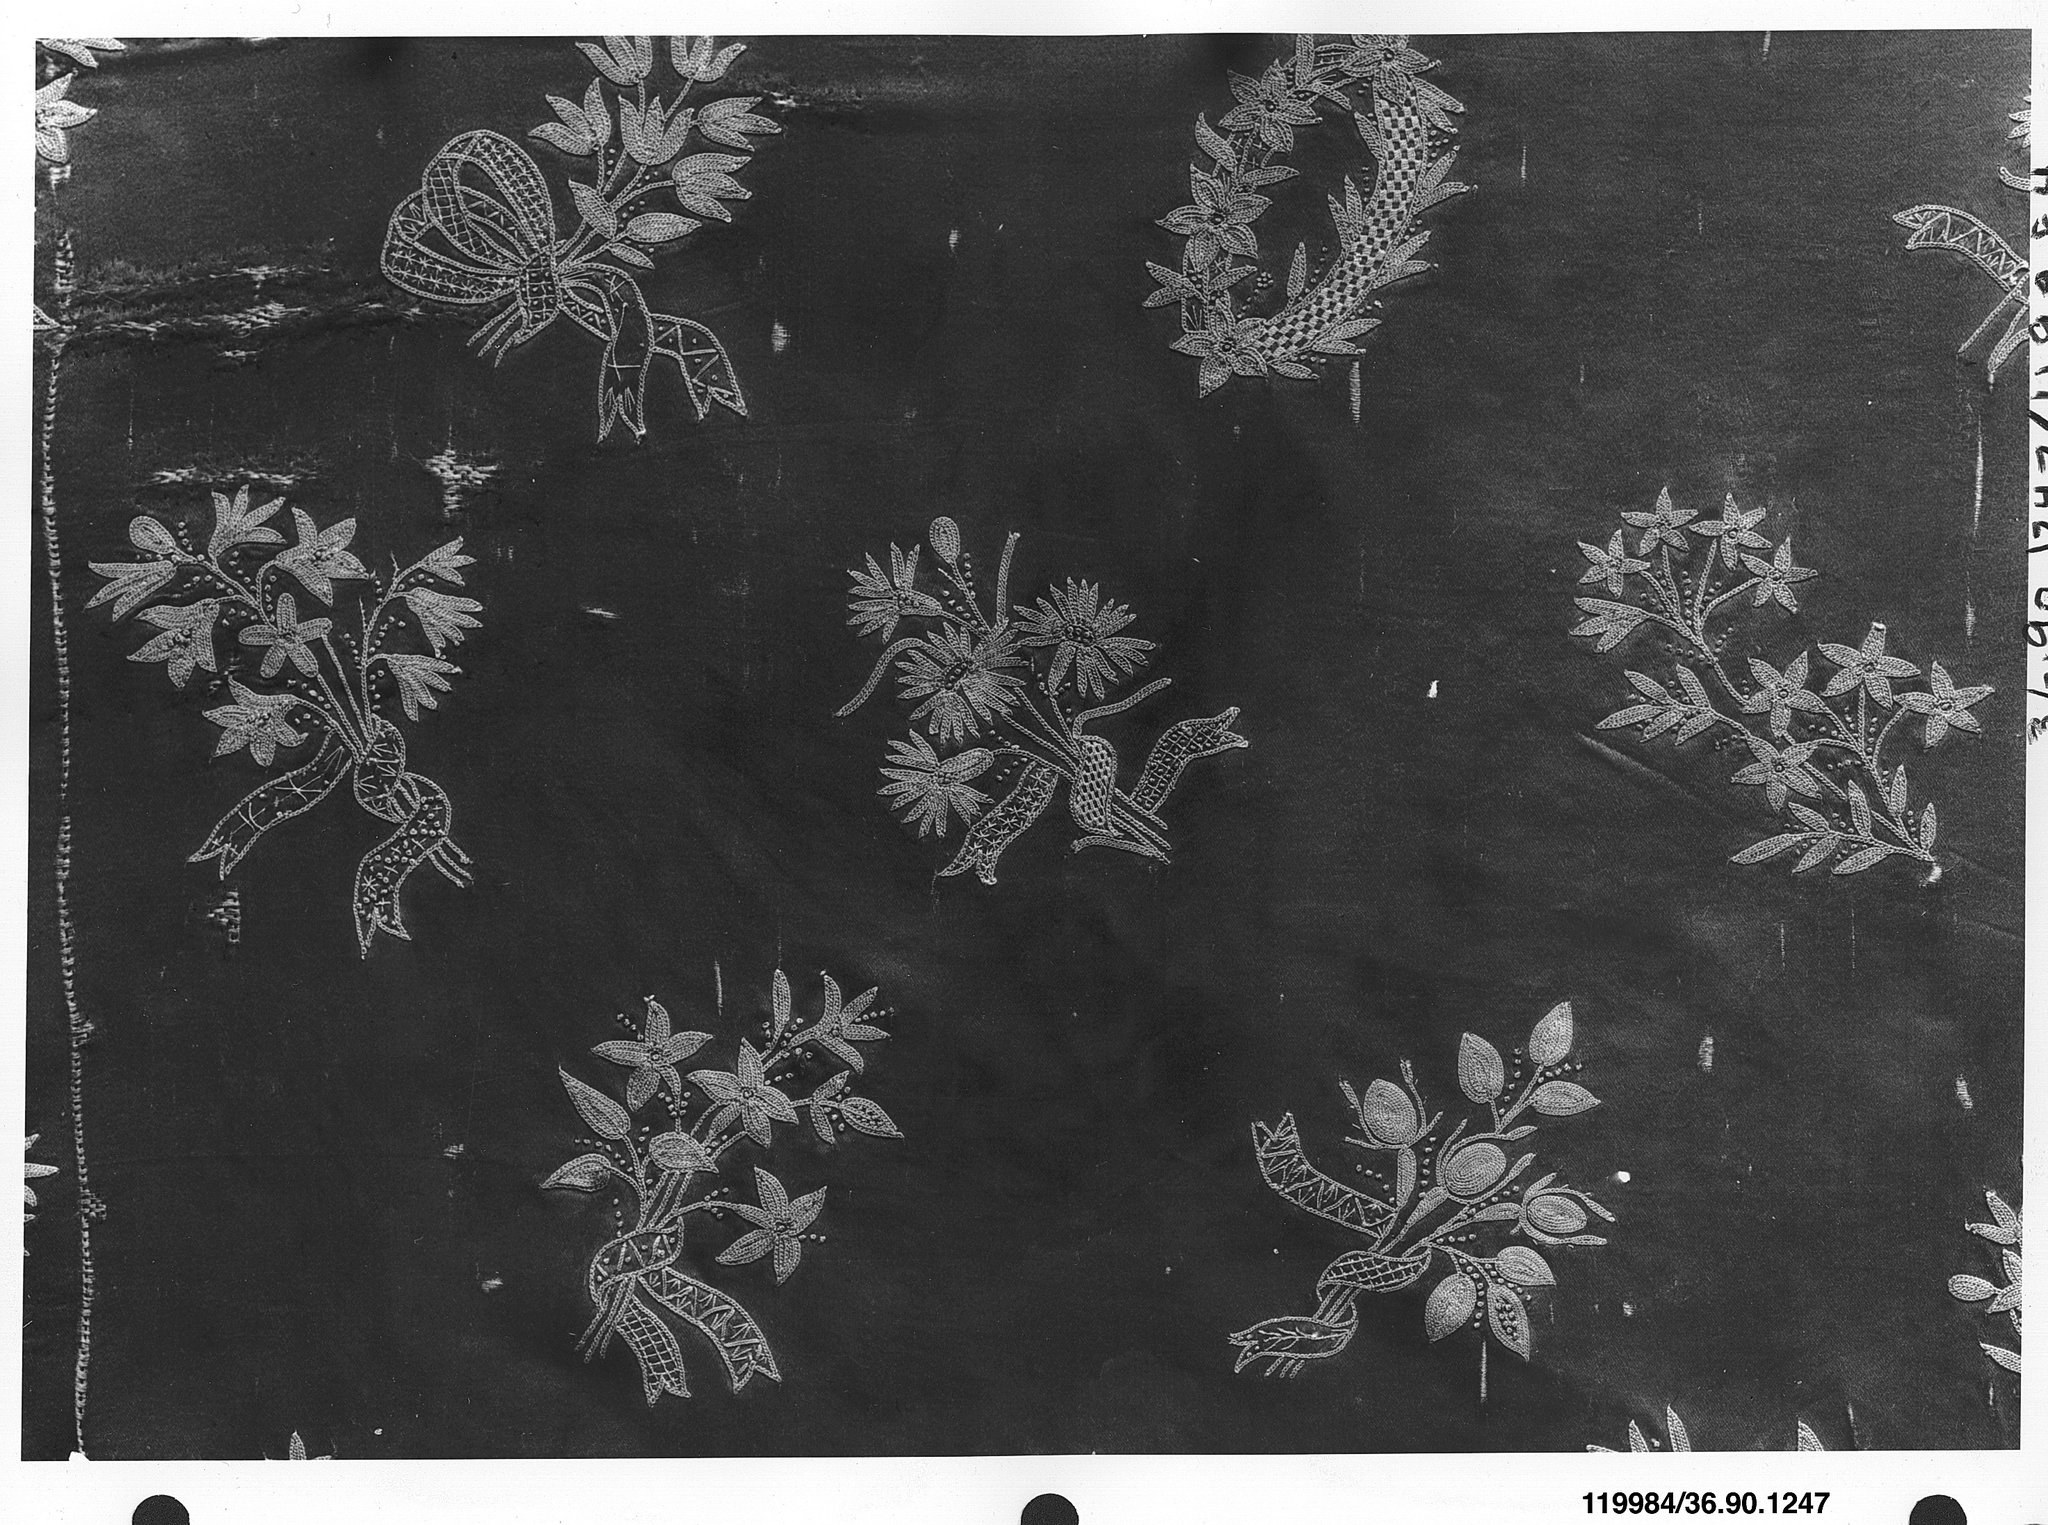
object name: piece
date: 1701-1800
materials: silk, thread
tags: flowers,leaves